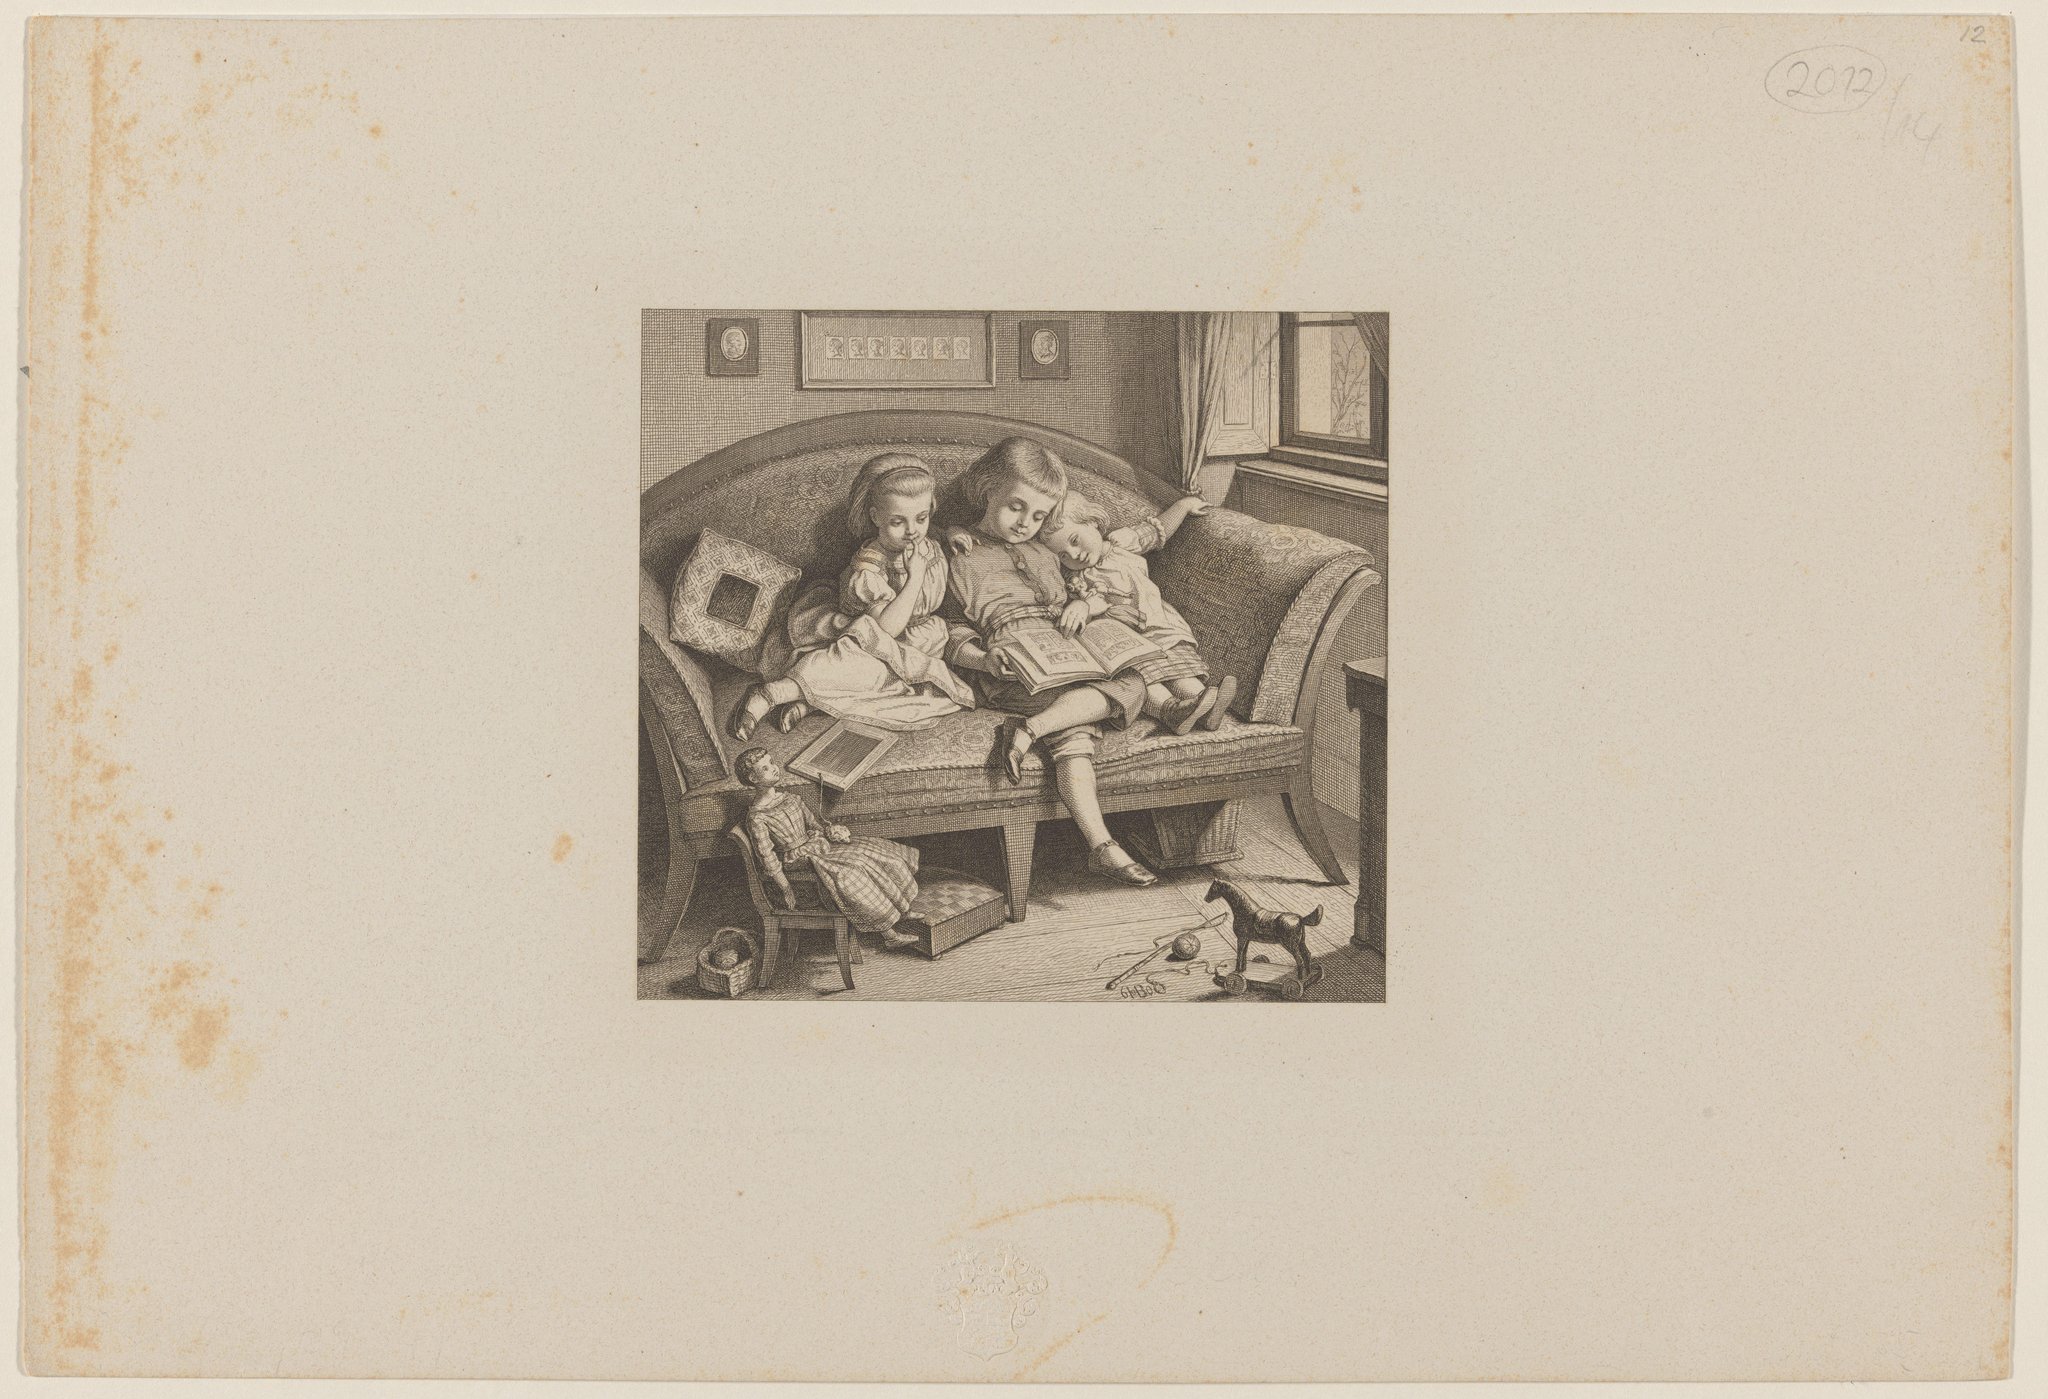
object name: print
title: Drie meisjes kijkend in een prentenboek (Das Bilderbuch)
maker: hugo bürkner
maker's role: print maker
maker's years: 1818-1897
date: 1860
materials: paper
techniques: etching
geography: germany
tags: reading a picture book, (playing with) toys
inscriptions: collector's mark: Lugt 2228, collector's mark: Lugt 2760, collector's mark:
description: Drie kinderen zitten naast elkaar op een bank samen een prentenboek te bekijken. Op de vloer ligt speelgoed.